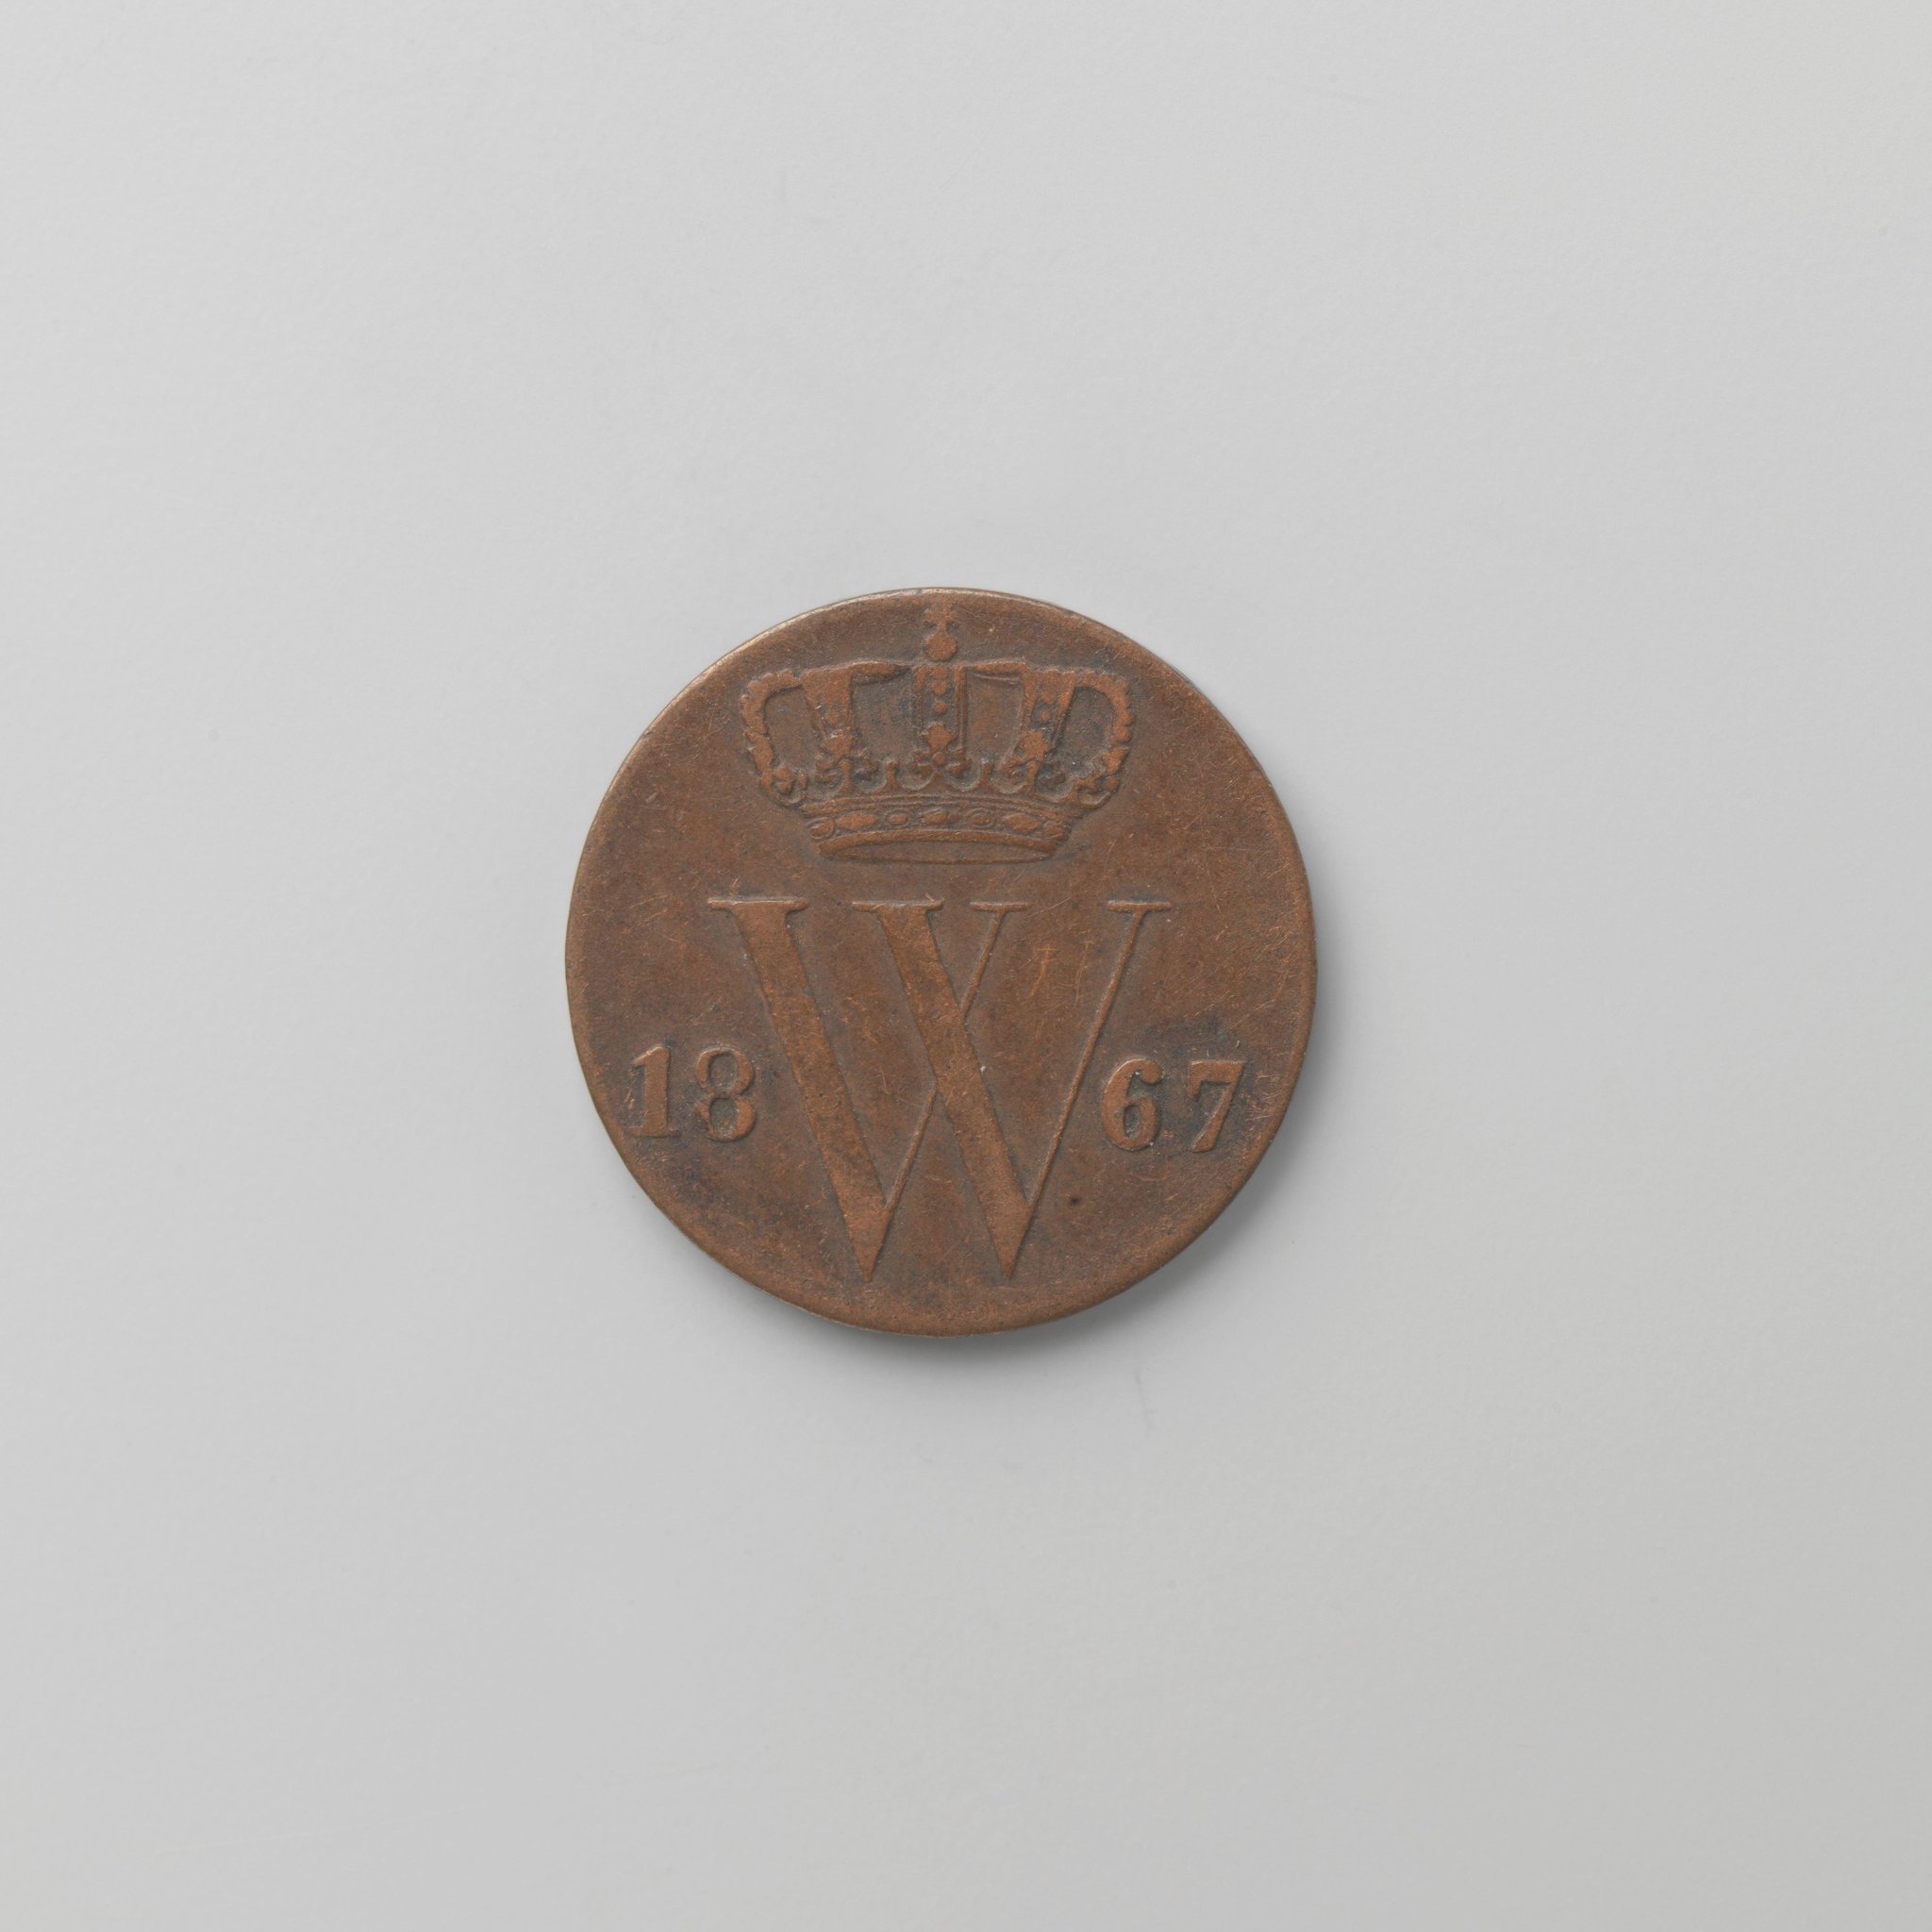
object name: coin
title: Nederland, ½ cent, 1867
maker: willem iii (koning der nederlanden)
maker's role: koning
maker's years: 1817-1890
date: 1867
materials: copper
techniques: striking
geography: utrecht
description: Koperen munt. Voorzijde: tussen jaartal gekroonde rechte letter W. Keerzijde: tussen waarde-aanduiding ½ C. gekroond rijkswapenschild. Gladde rand.